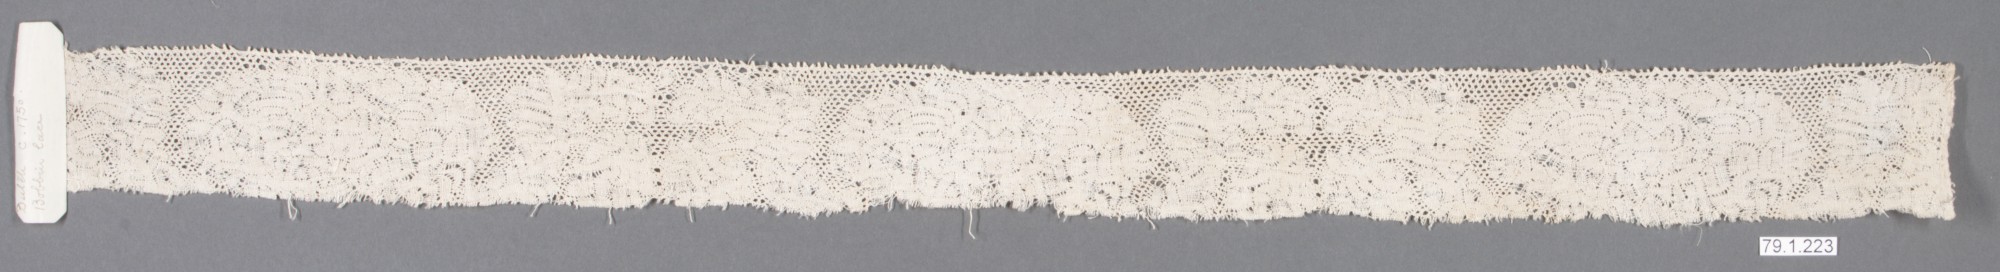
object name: strip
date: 1601-1800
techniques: lace